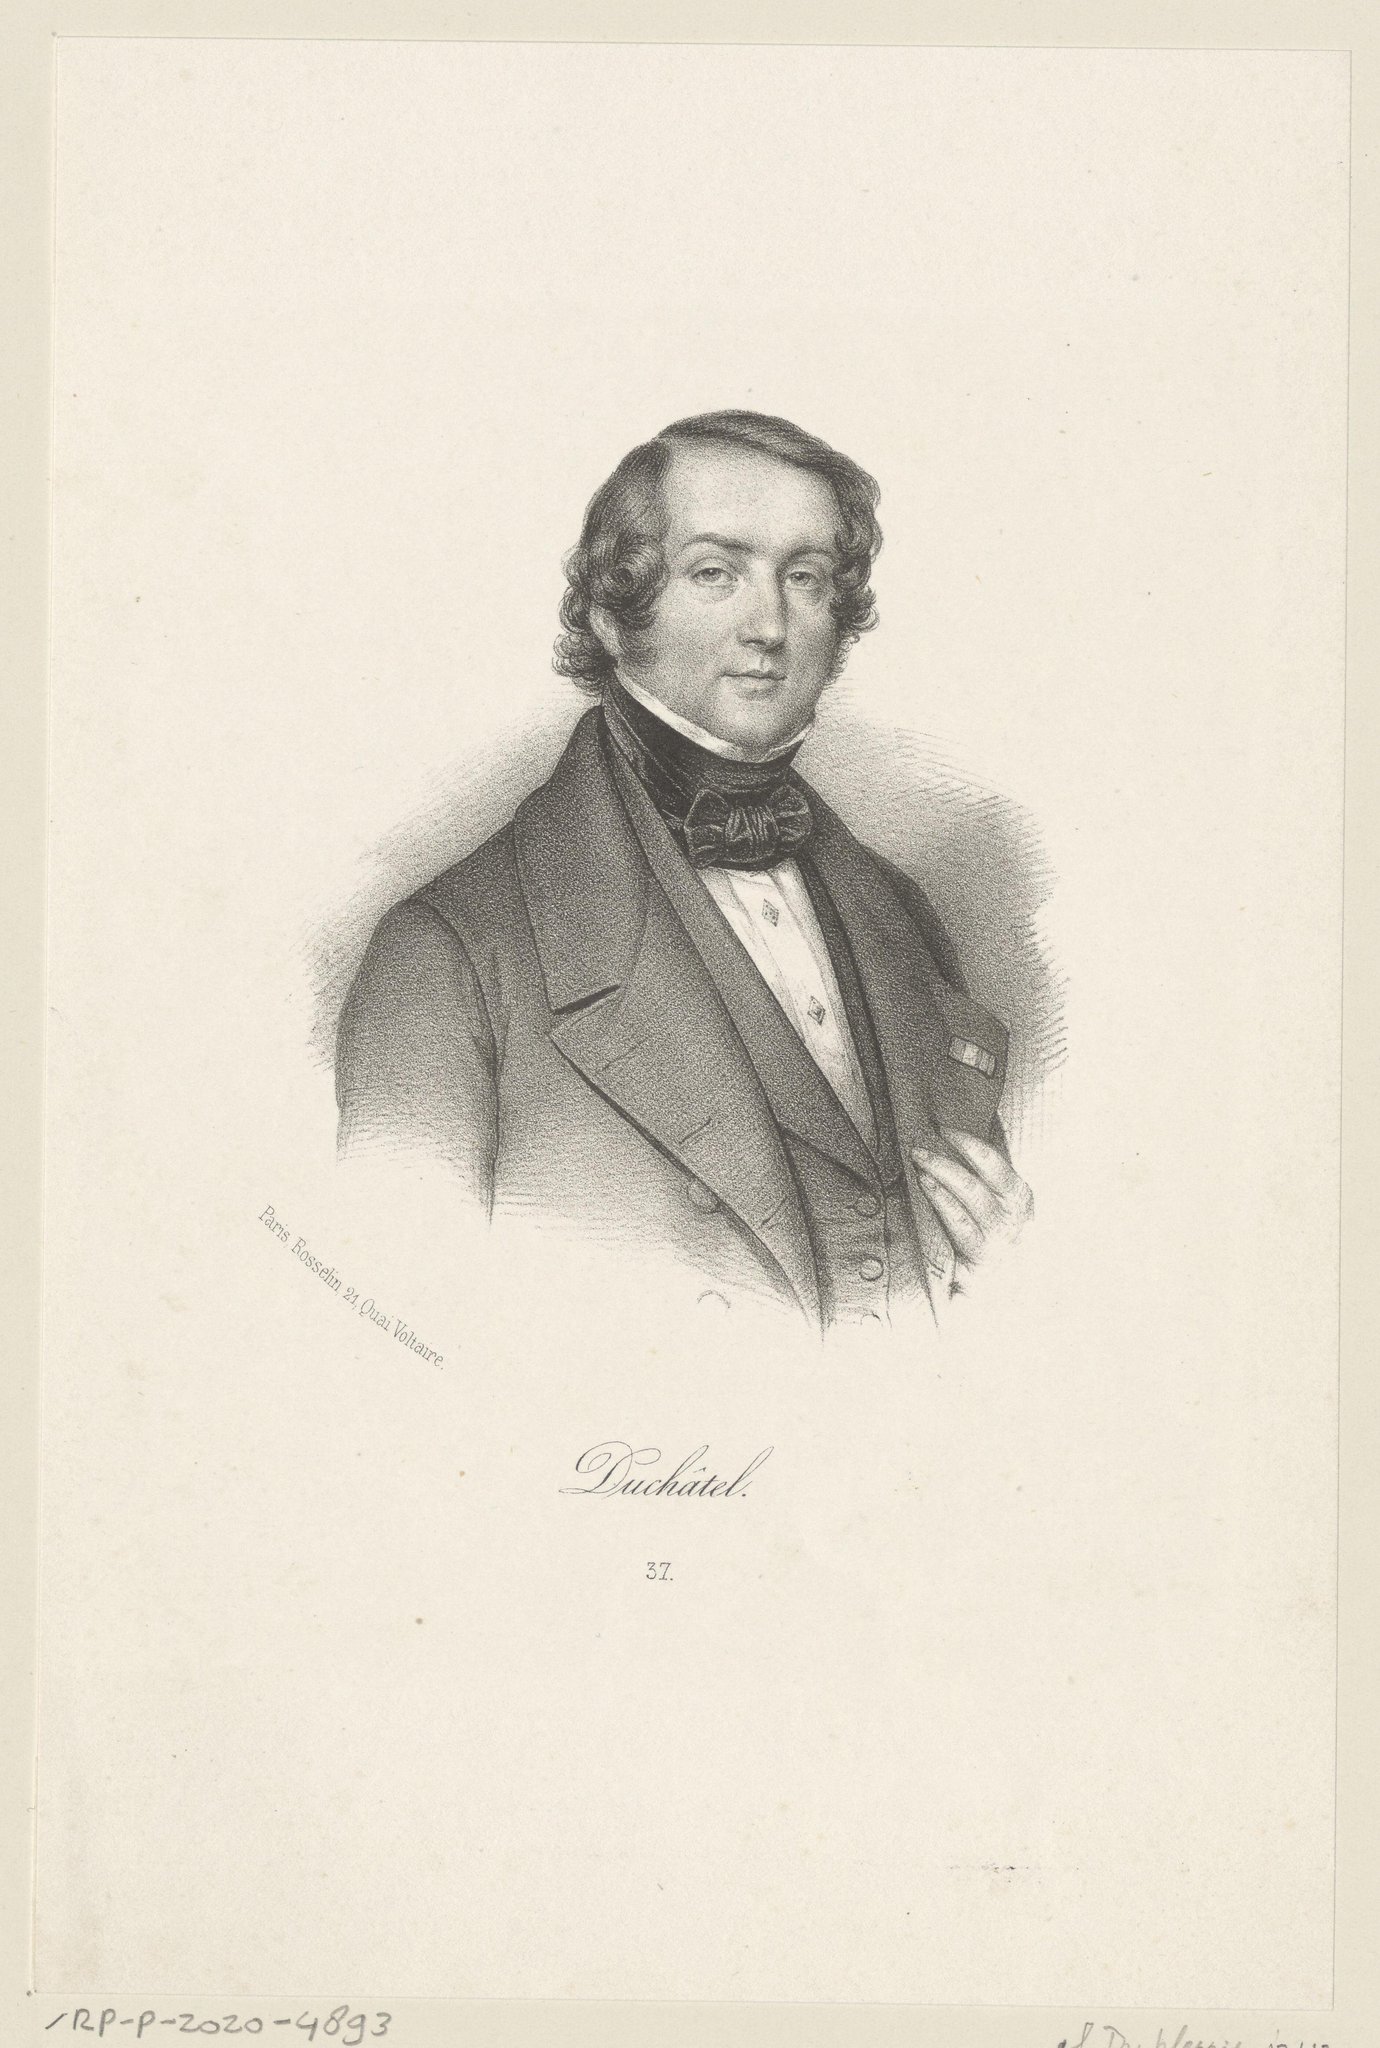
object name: print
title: Portret van graaf Charles Marie Tanneguy Duchâtel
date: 1836-1861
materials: paper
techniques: lithograph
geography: paris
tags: paris, historical persons, politician, e.g. party leader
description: Prent maakt mogelijk deel uit van een serie.